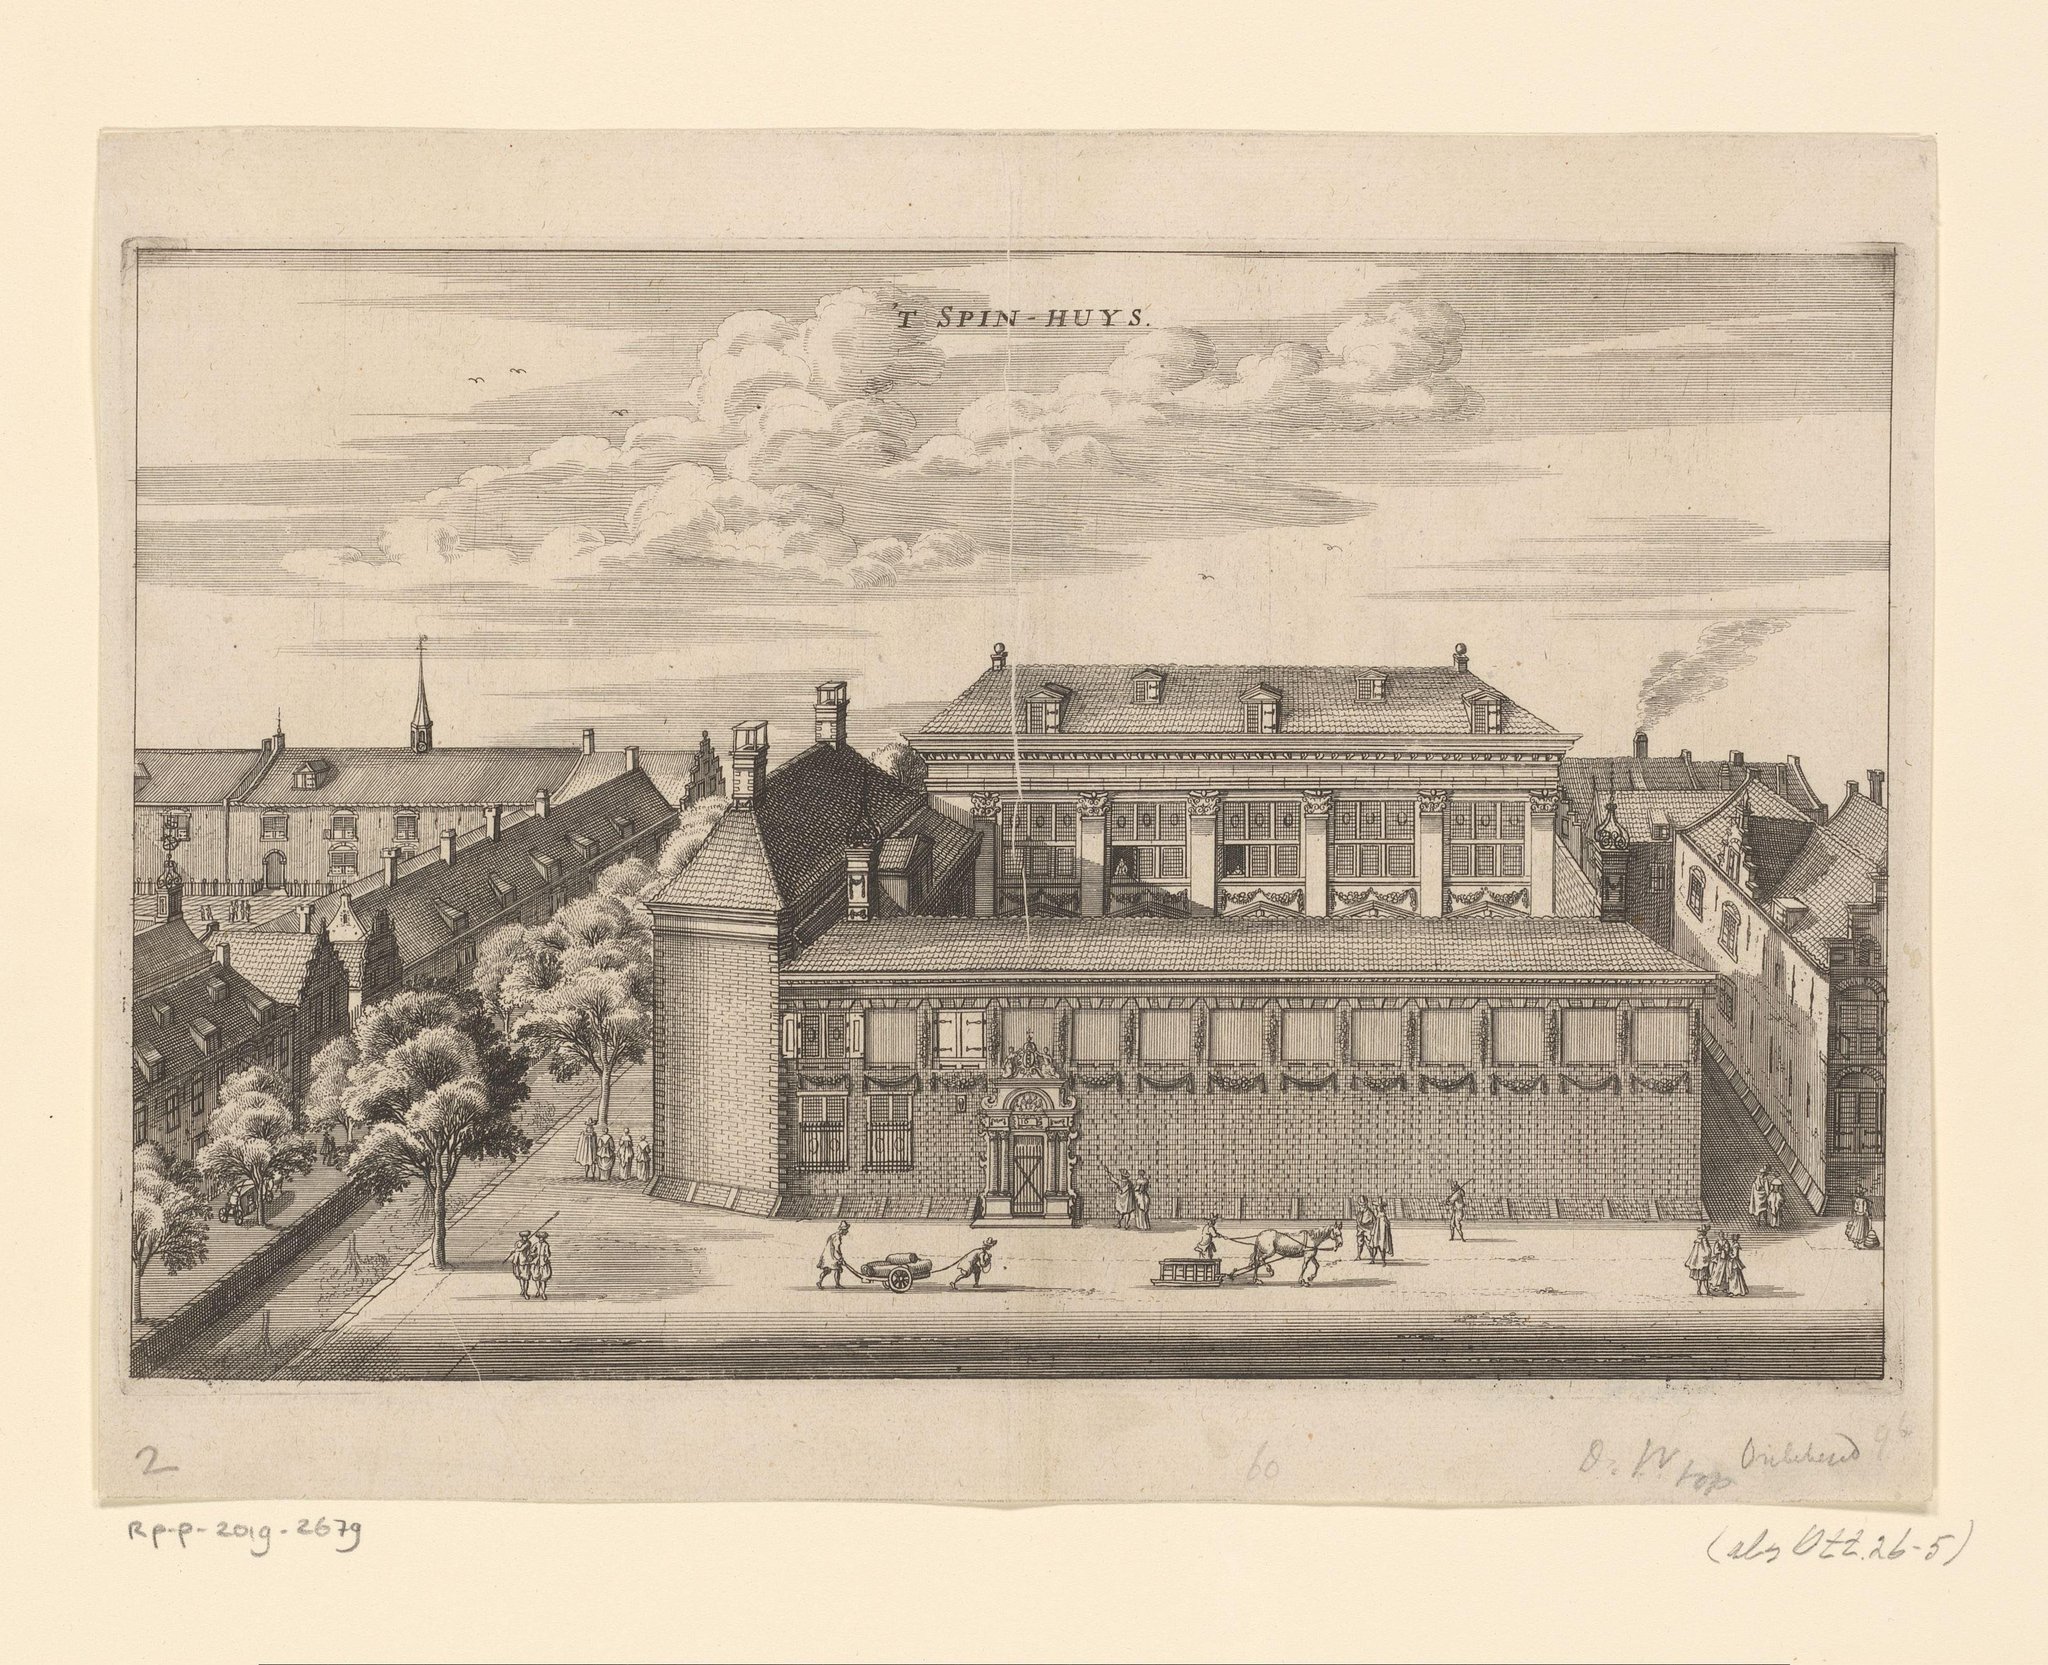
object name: book illustration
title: ’t Spin-huys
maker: jacob van meurs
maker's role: draughtsman, print maker, publisher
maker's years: 1619-1680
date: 1663-1664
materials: paper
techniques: etching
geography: amsterdam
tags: prison, jail, gate, entrance, canals, waters (in city), workhouse, penal camp, penitentiary, chain gang, street (+ city(-scape) with figures, staffage)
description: Huidige staat van prent gebruikt in: Dapper, Olfert. Historische beschryving der stadt Amsterdam: waer in de voornaemste geschiedenissen (na een kort verhael van gansch Hollant en d'omleggende dorpen (…). Amsterdam: Jacob van Meurs, 1663.* En in: Zesen, Philipp von. Beschreibung der Stadt Amsterdam: darinnen von derselben ersten Ursprunge bis auf gegenwärtigen Zustand (…). Amsterdam: Joachim Nosche, 1664. * In sommige exemplaren van deze uitgave komt de huidige staat van de prent voor. In andere exemplaren is een latere staat ingebonden, waarop boven de Nederlandse een Franse titel is toegevoegd.